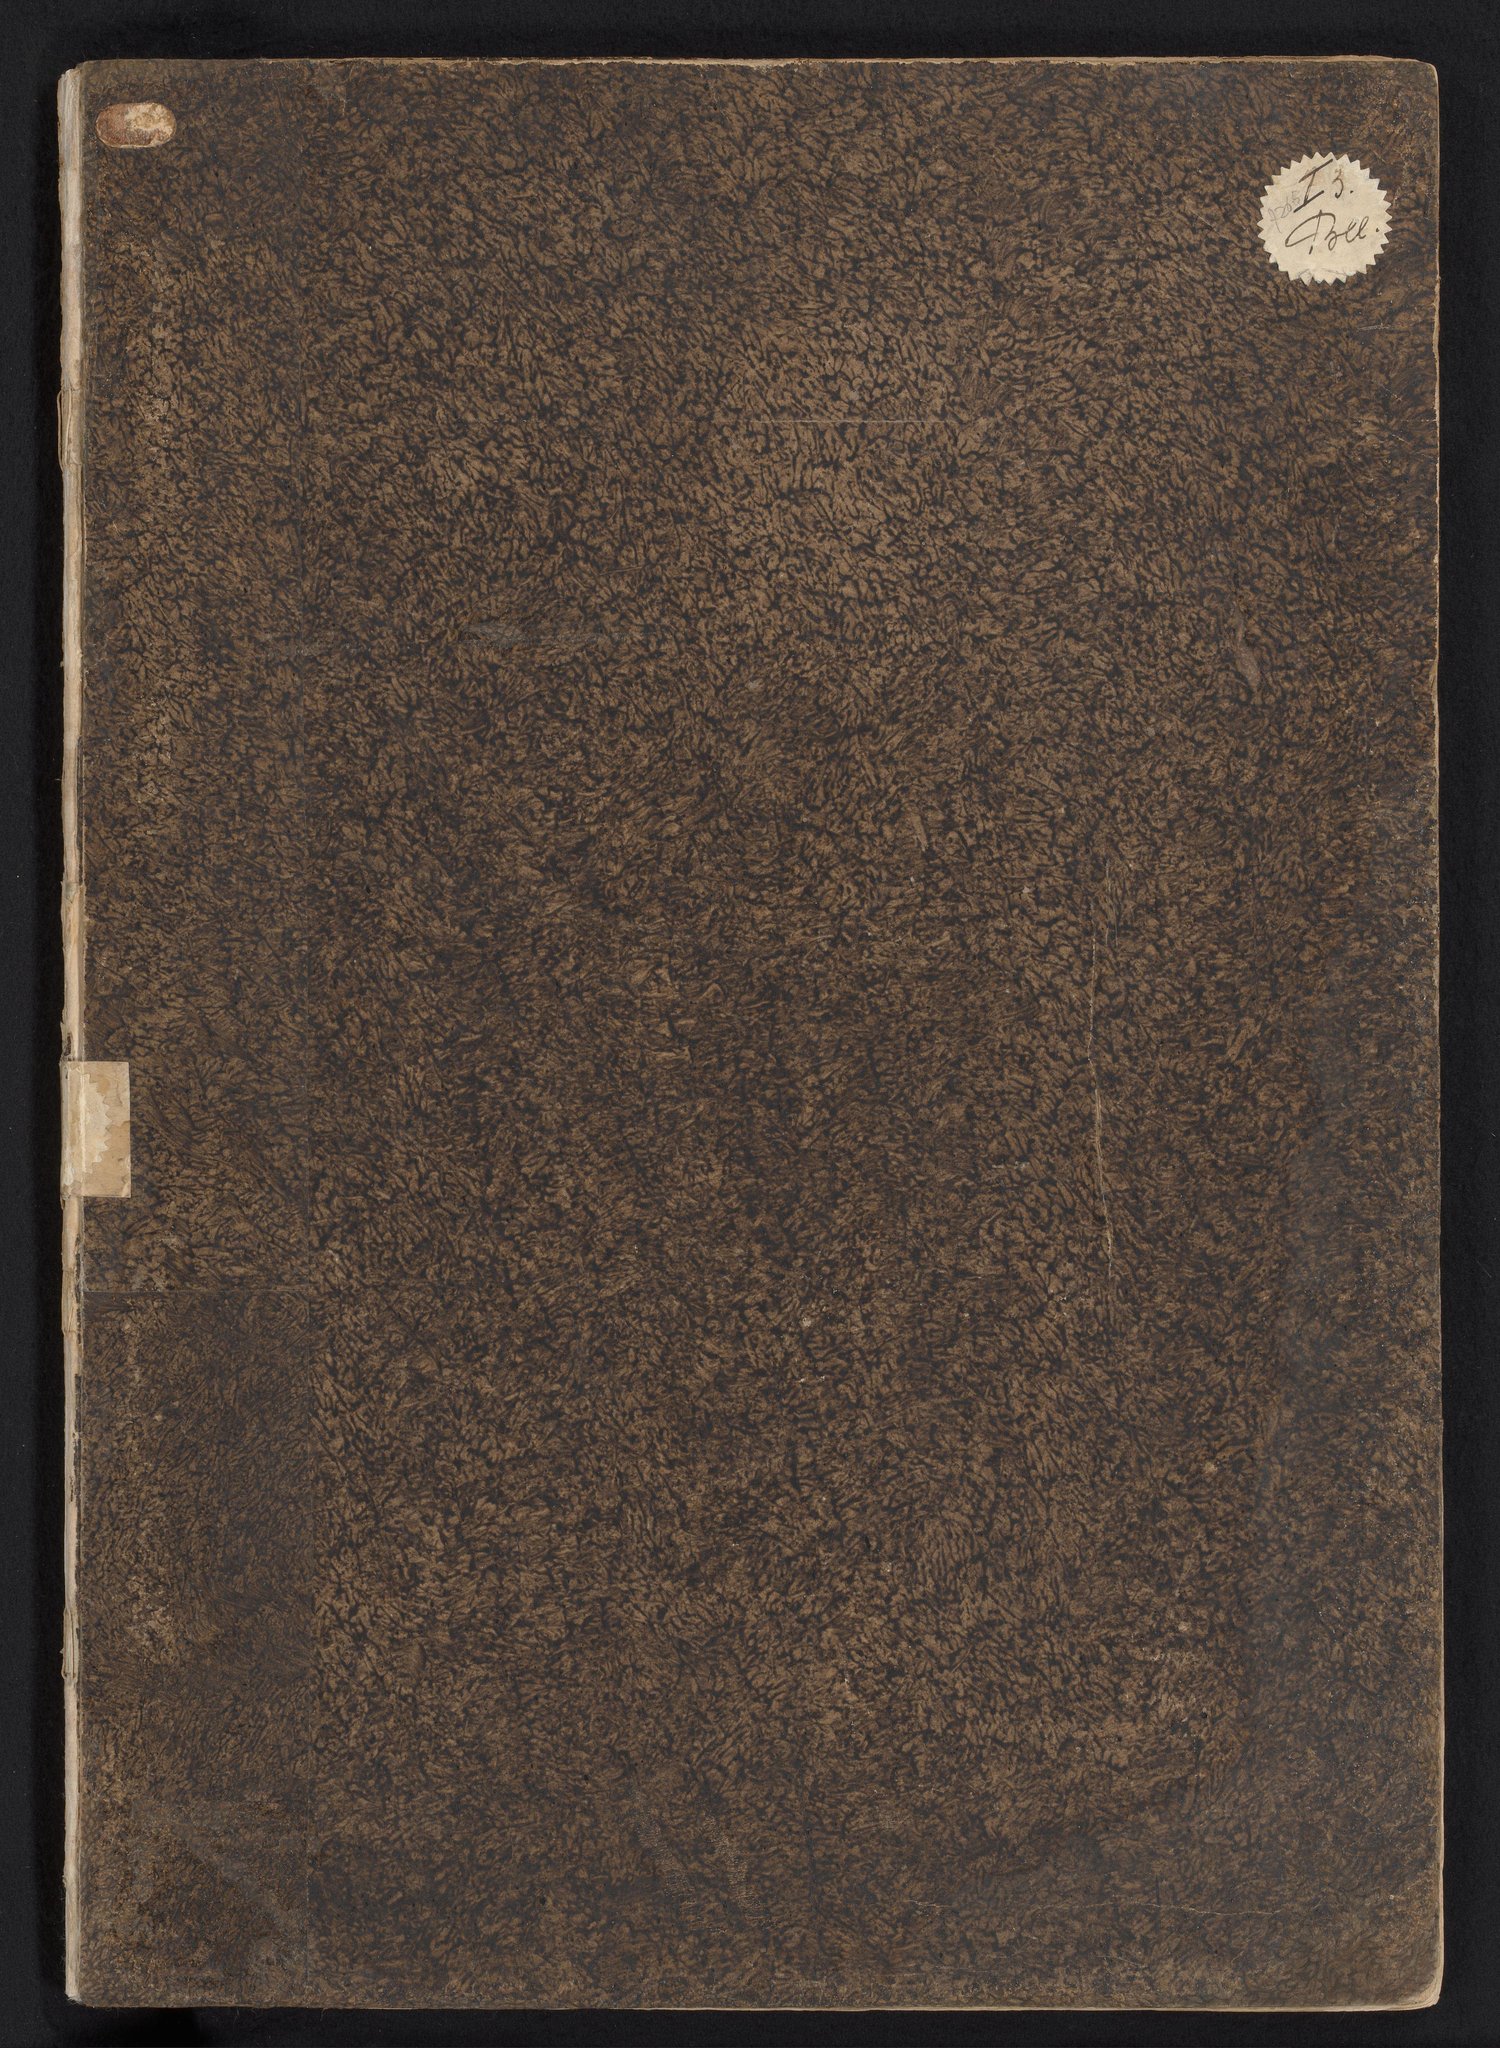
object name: prentrecueil, prentenalbum, prentalbum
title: Album met voorstellingen van beeldhouwwerken in en op het Paleis op de Dam te Amsterdam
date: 1655-1668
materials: cardboard, paper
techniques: engraving, etching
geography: amsterdam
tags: sculpture, royal palace of amsterdam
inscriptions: collector's mark: ‘Kunstnijverheidschool Quellinus Amsterdam Frans Halsstraat 14’, collector's mark: ‘Instituut voor kunst-nijverheidsonderwijs Gabriël Metsustraat No. 16 Amsterdam’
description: Album met een ex libris en twaalf prenten op twaalf bladen, met voor en achter schutbladen. Negen prenten zijn door Hubert Quellinus gemaakt en drie door Dancker of Cornelis Danckerts. Factice album, dat wil zeggen: een door een verzamelaar of eigenaar van de prenten samengesteld album.